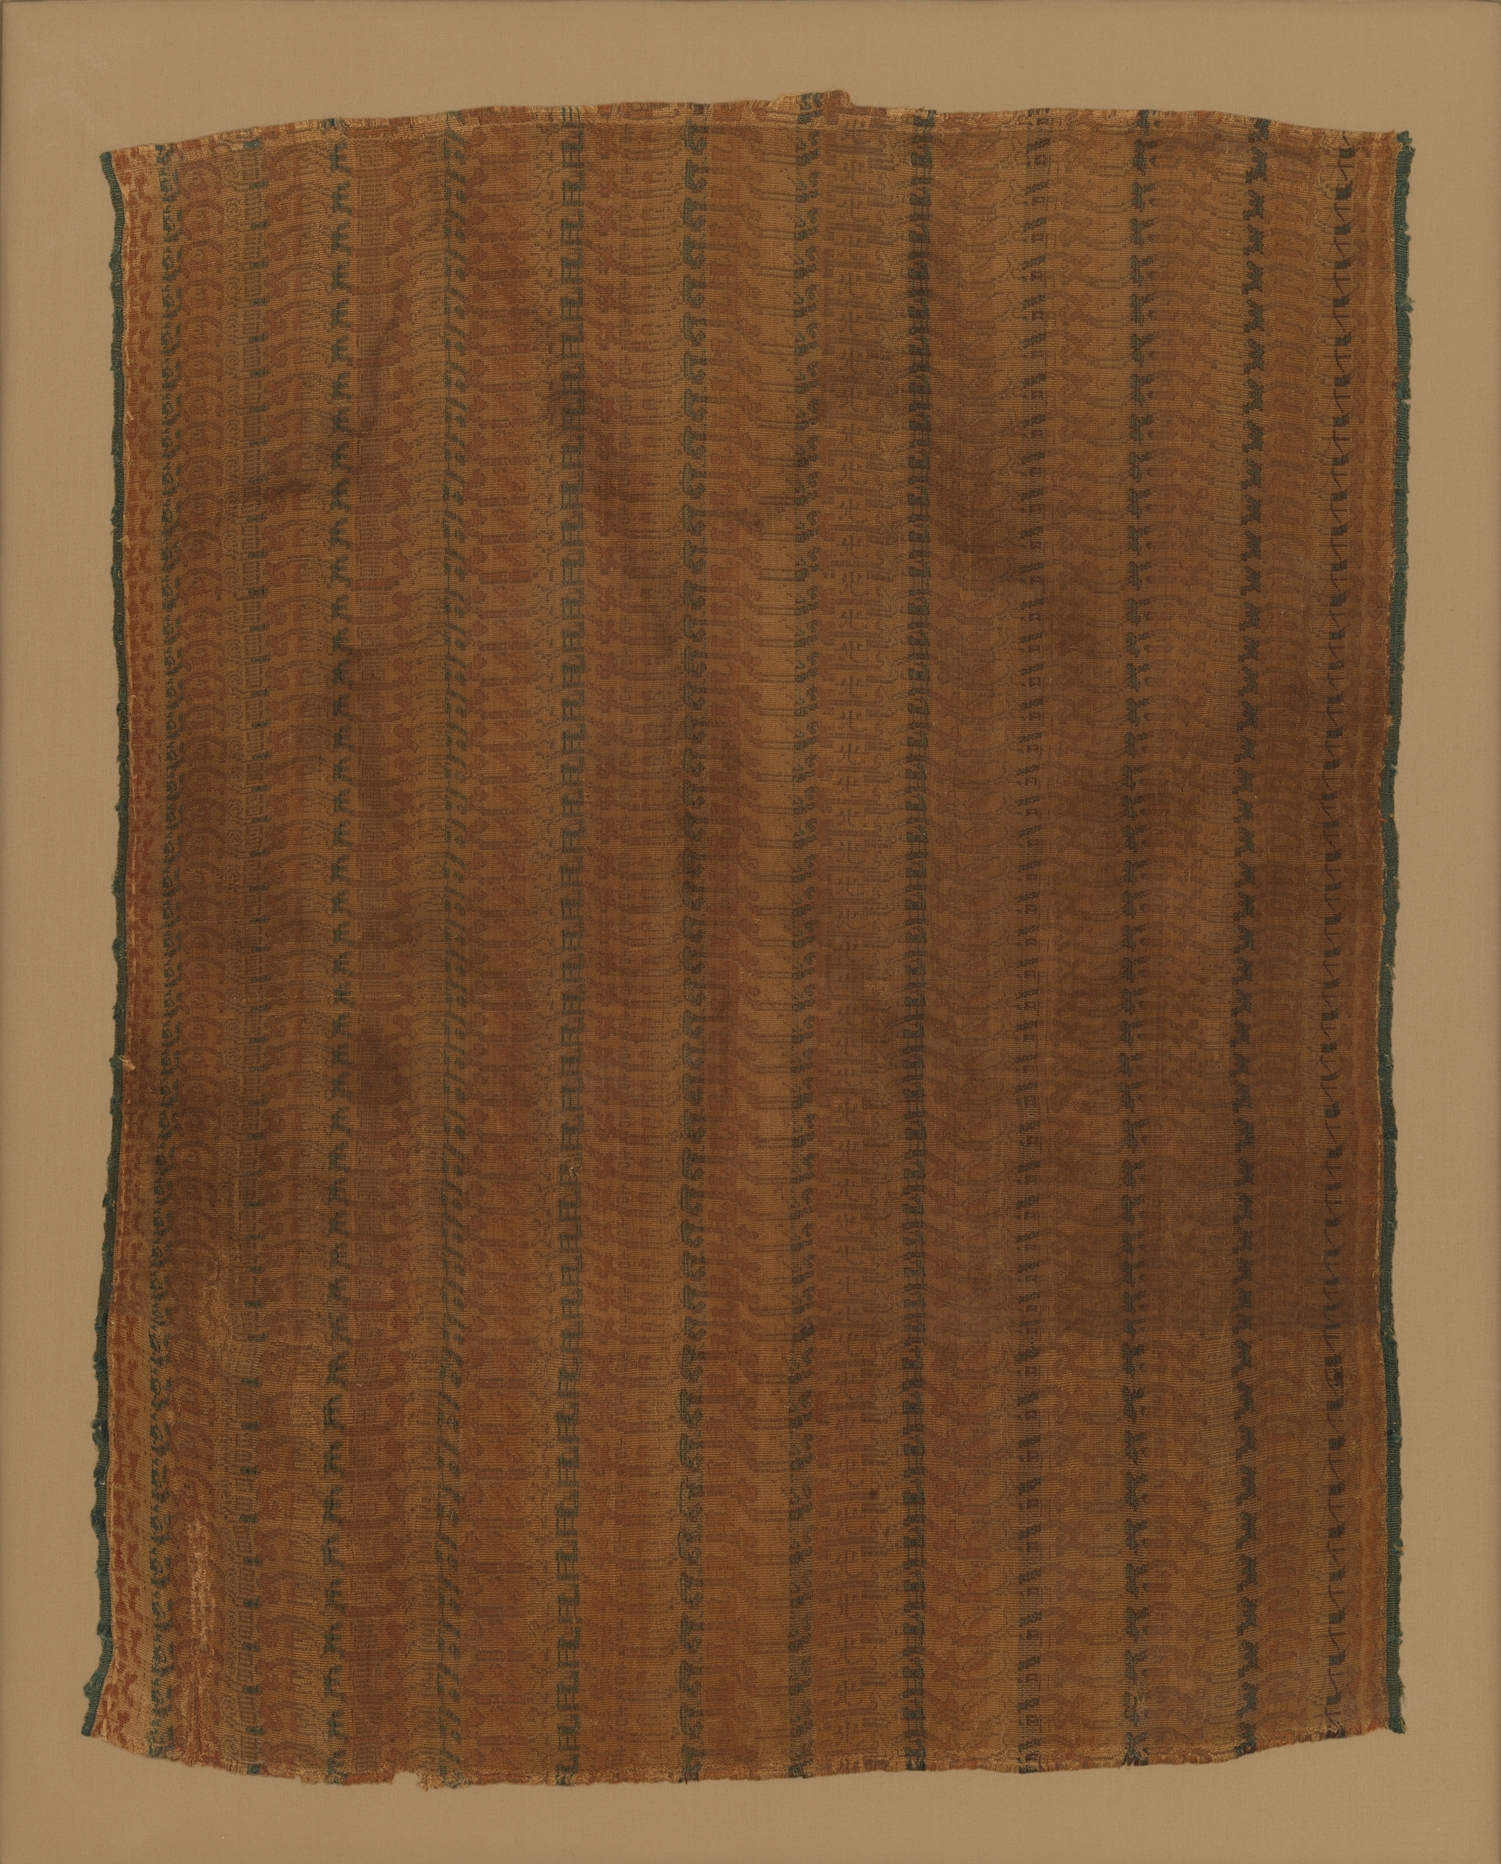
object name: panel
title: Textile with deer and a woven inscription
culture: chinese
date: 201-500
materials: silk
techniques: weave